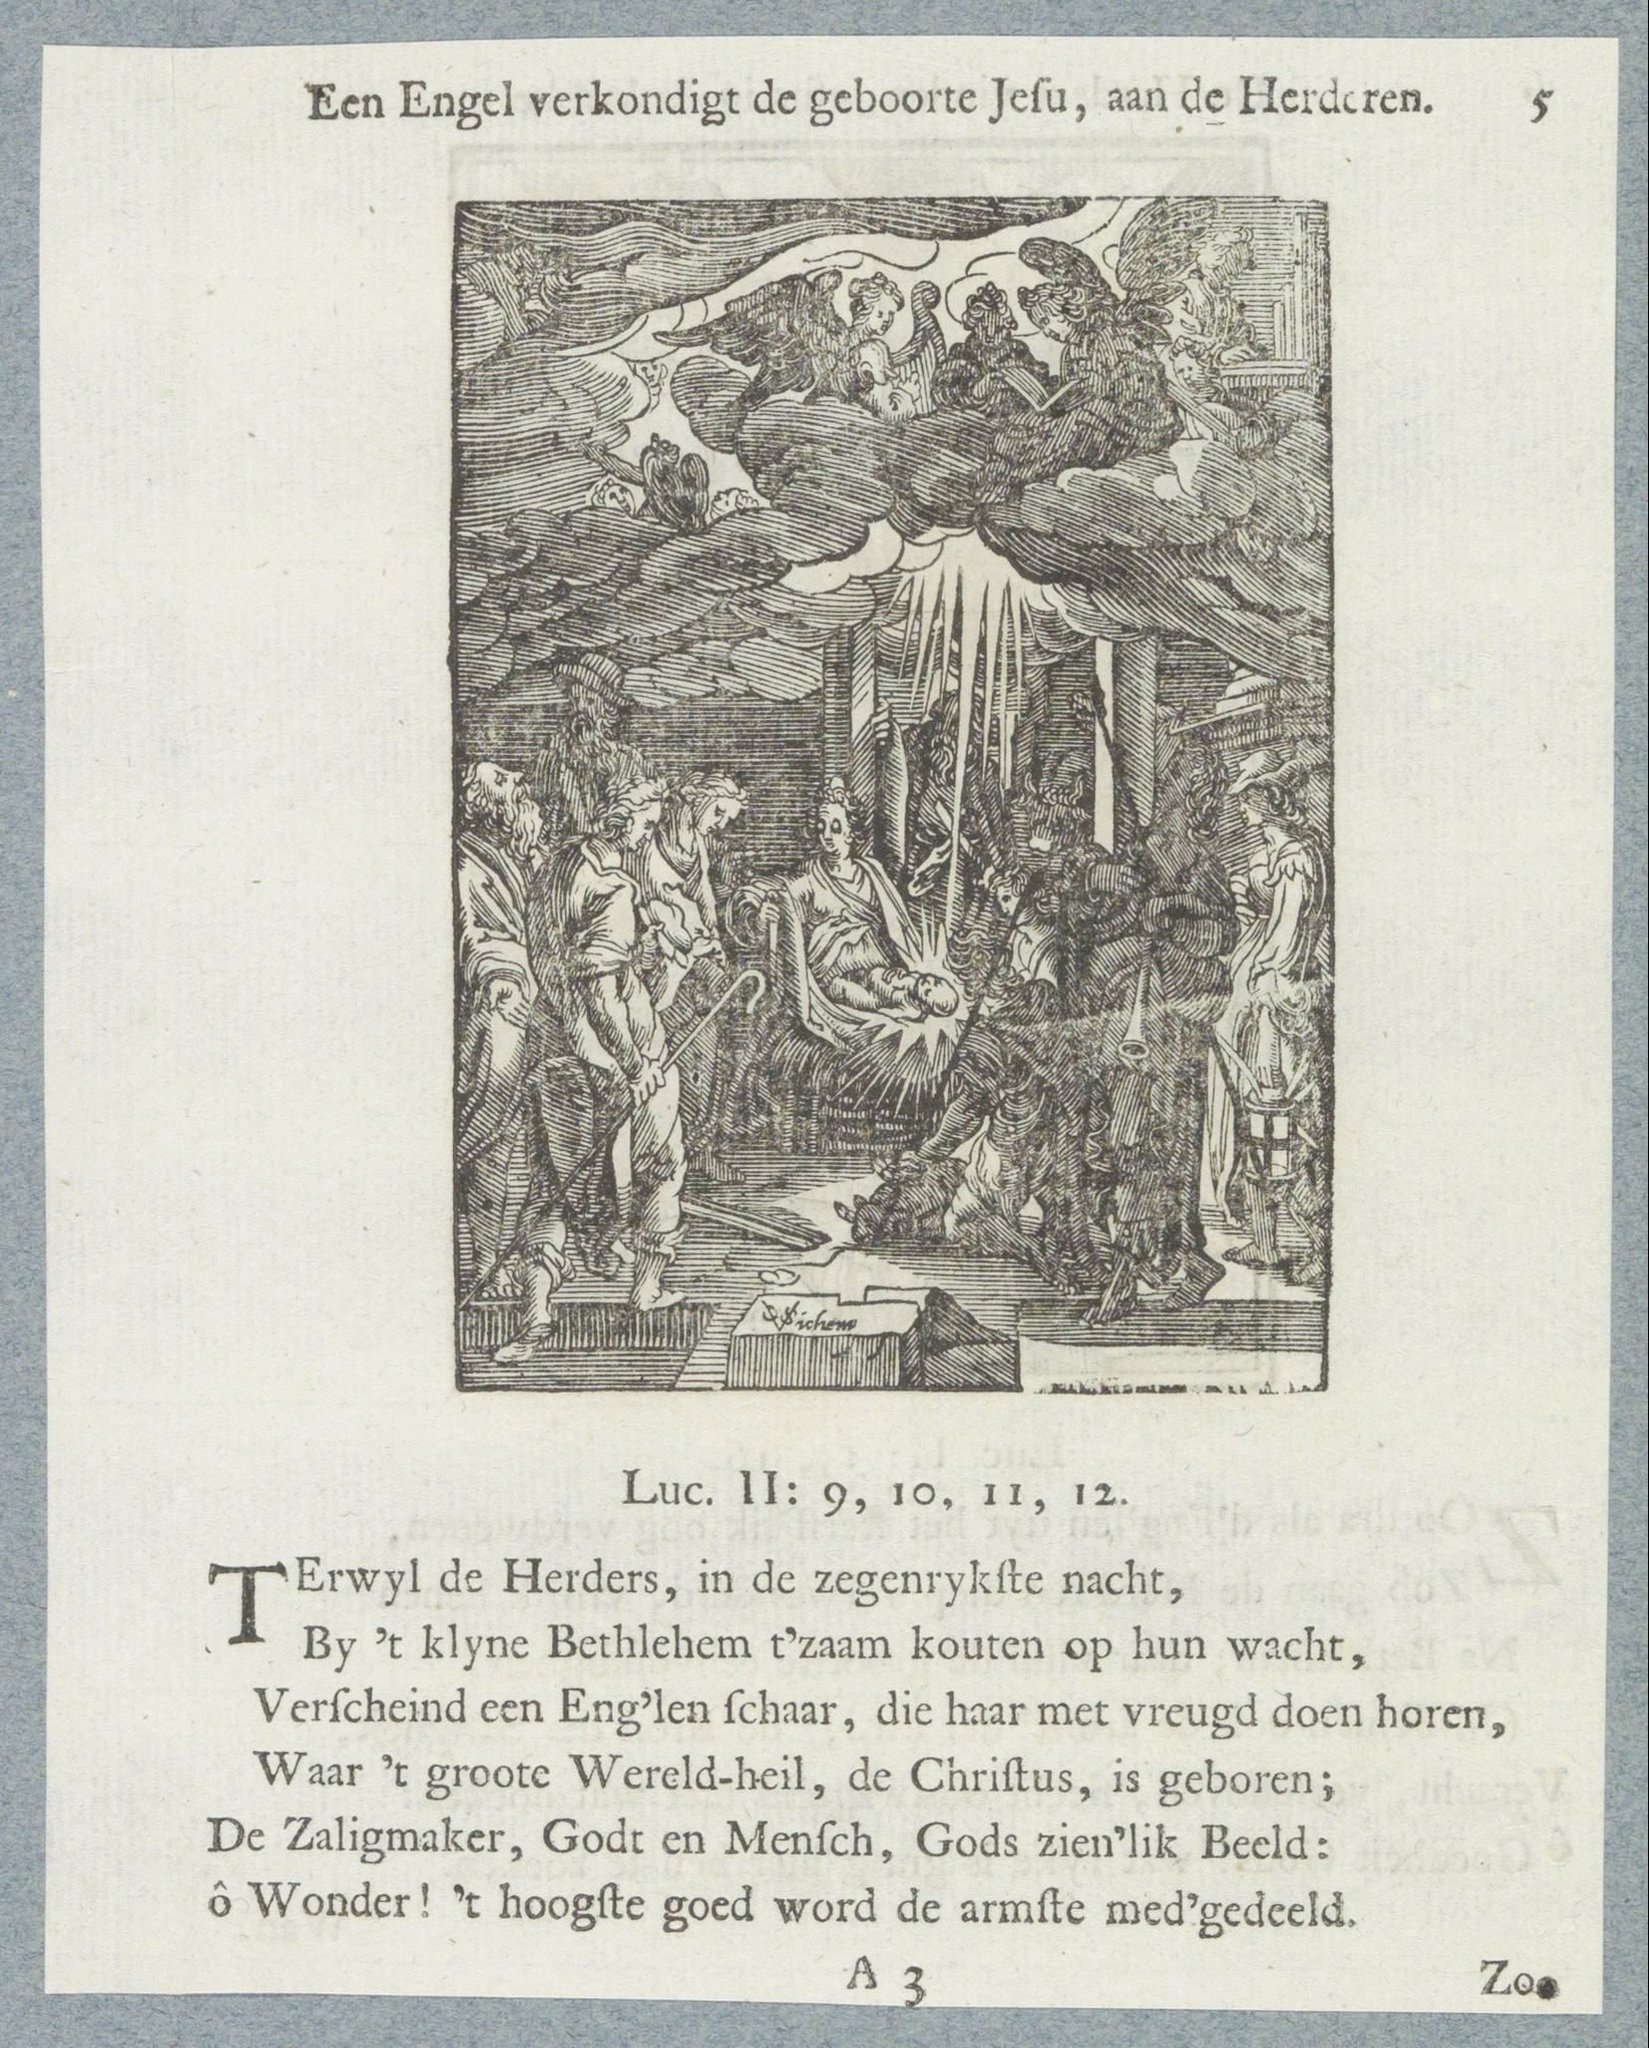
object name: book illustration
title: Een engel verkondigt de geboorte Jesu, aan de herderen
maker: jan klooster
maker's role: bookseller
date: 1629-1648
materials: paper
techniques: letterpress printing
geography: amsterdam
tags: adoration of the christ-child by the shepherds; mary and joseph present (+ angel(s))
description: De herders aanbidden het Christuskind. Maria staat bij de kribbe. Op de wolken musicerende engelen. Boven de voorstelling een titel. Eronder zes versregels en een verwijzing naar Lucas 2: 9-12. De prent maakt deel uit van een album.